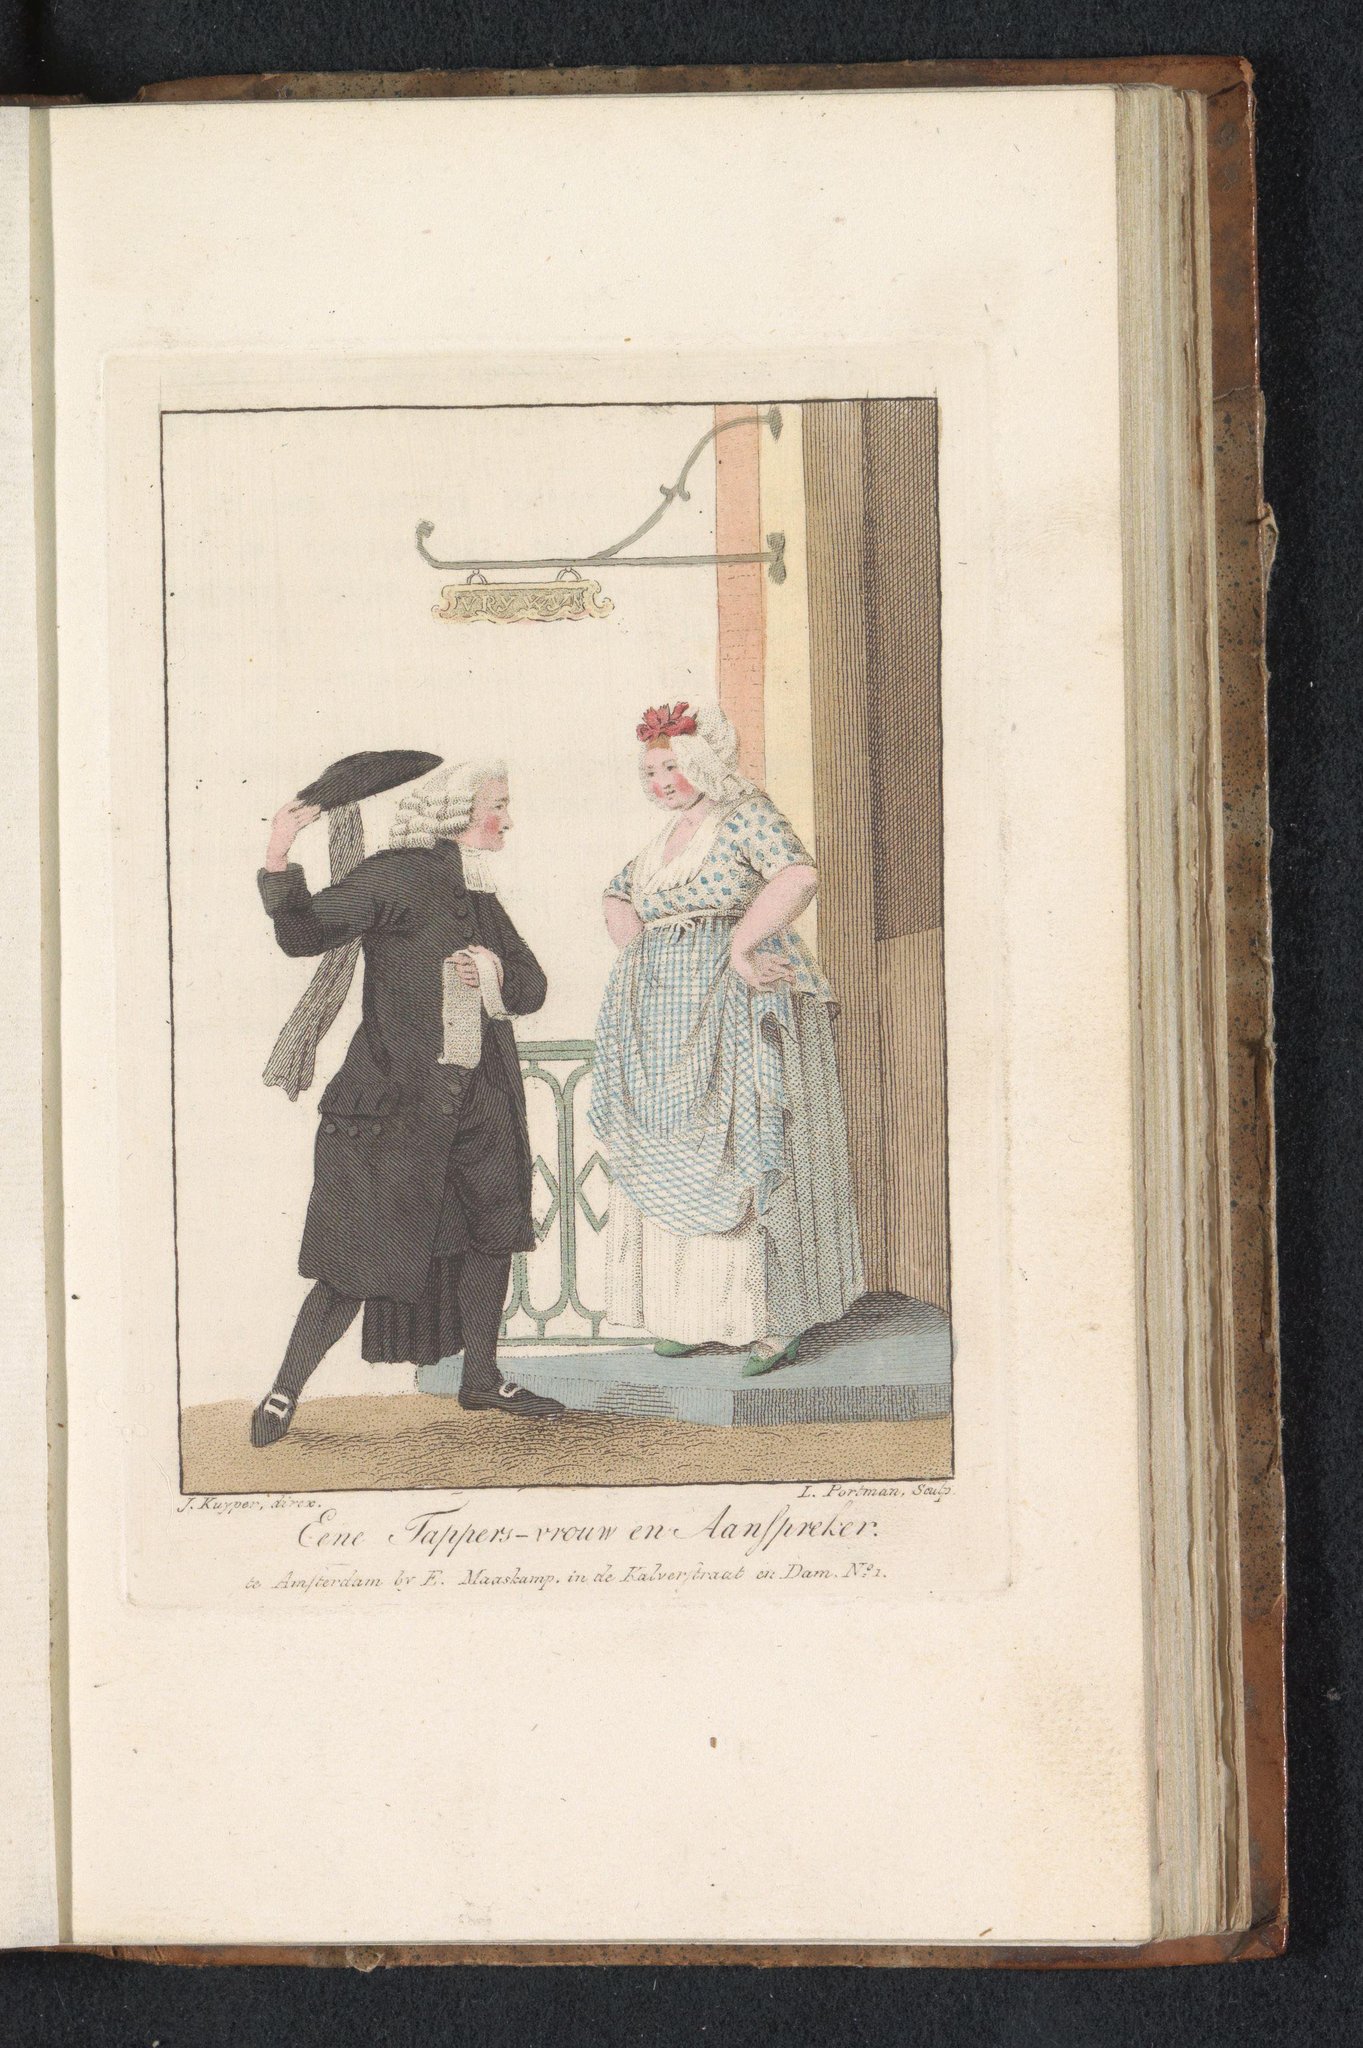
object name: costume print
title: Aanspreker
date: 1806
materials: paper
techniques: etching, hand coloring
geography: netherlands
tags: oral announcement (of death), undertaker's man, clothes, costume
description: Een aanspreker (aanzegger) deelt het overlijden van iemand mee aan een huisvrouw in de deuropening van een wijnhuis. Op het uithangbord: Vry Wyn. Onderdeel van de verkleinde kopieën uit 1806 naar de platen van Nederlandse klederdrachten uit de jaren 1803-1807.